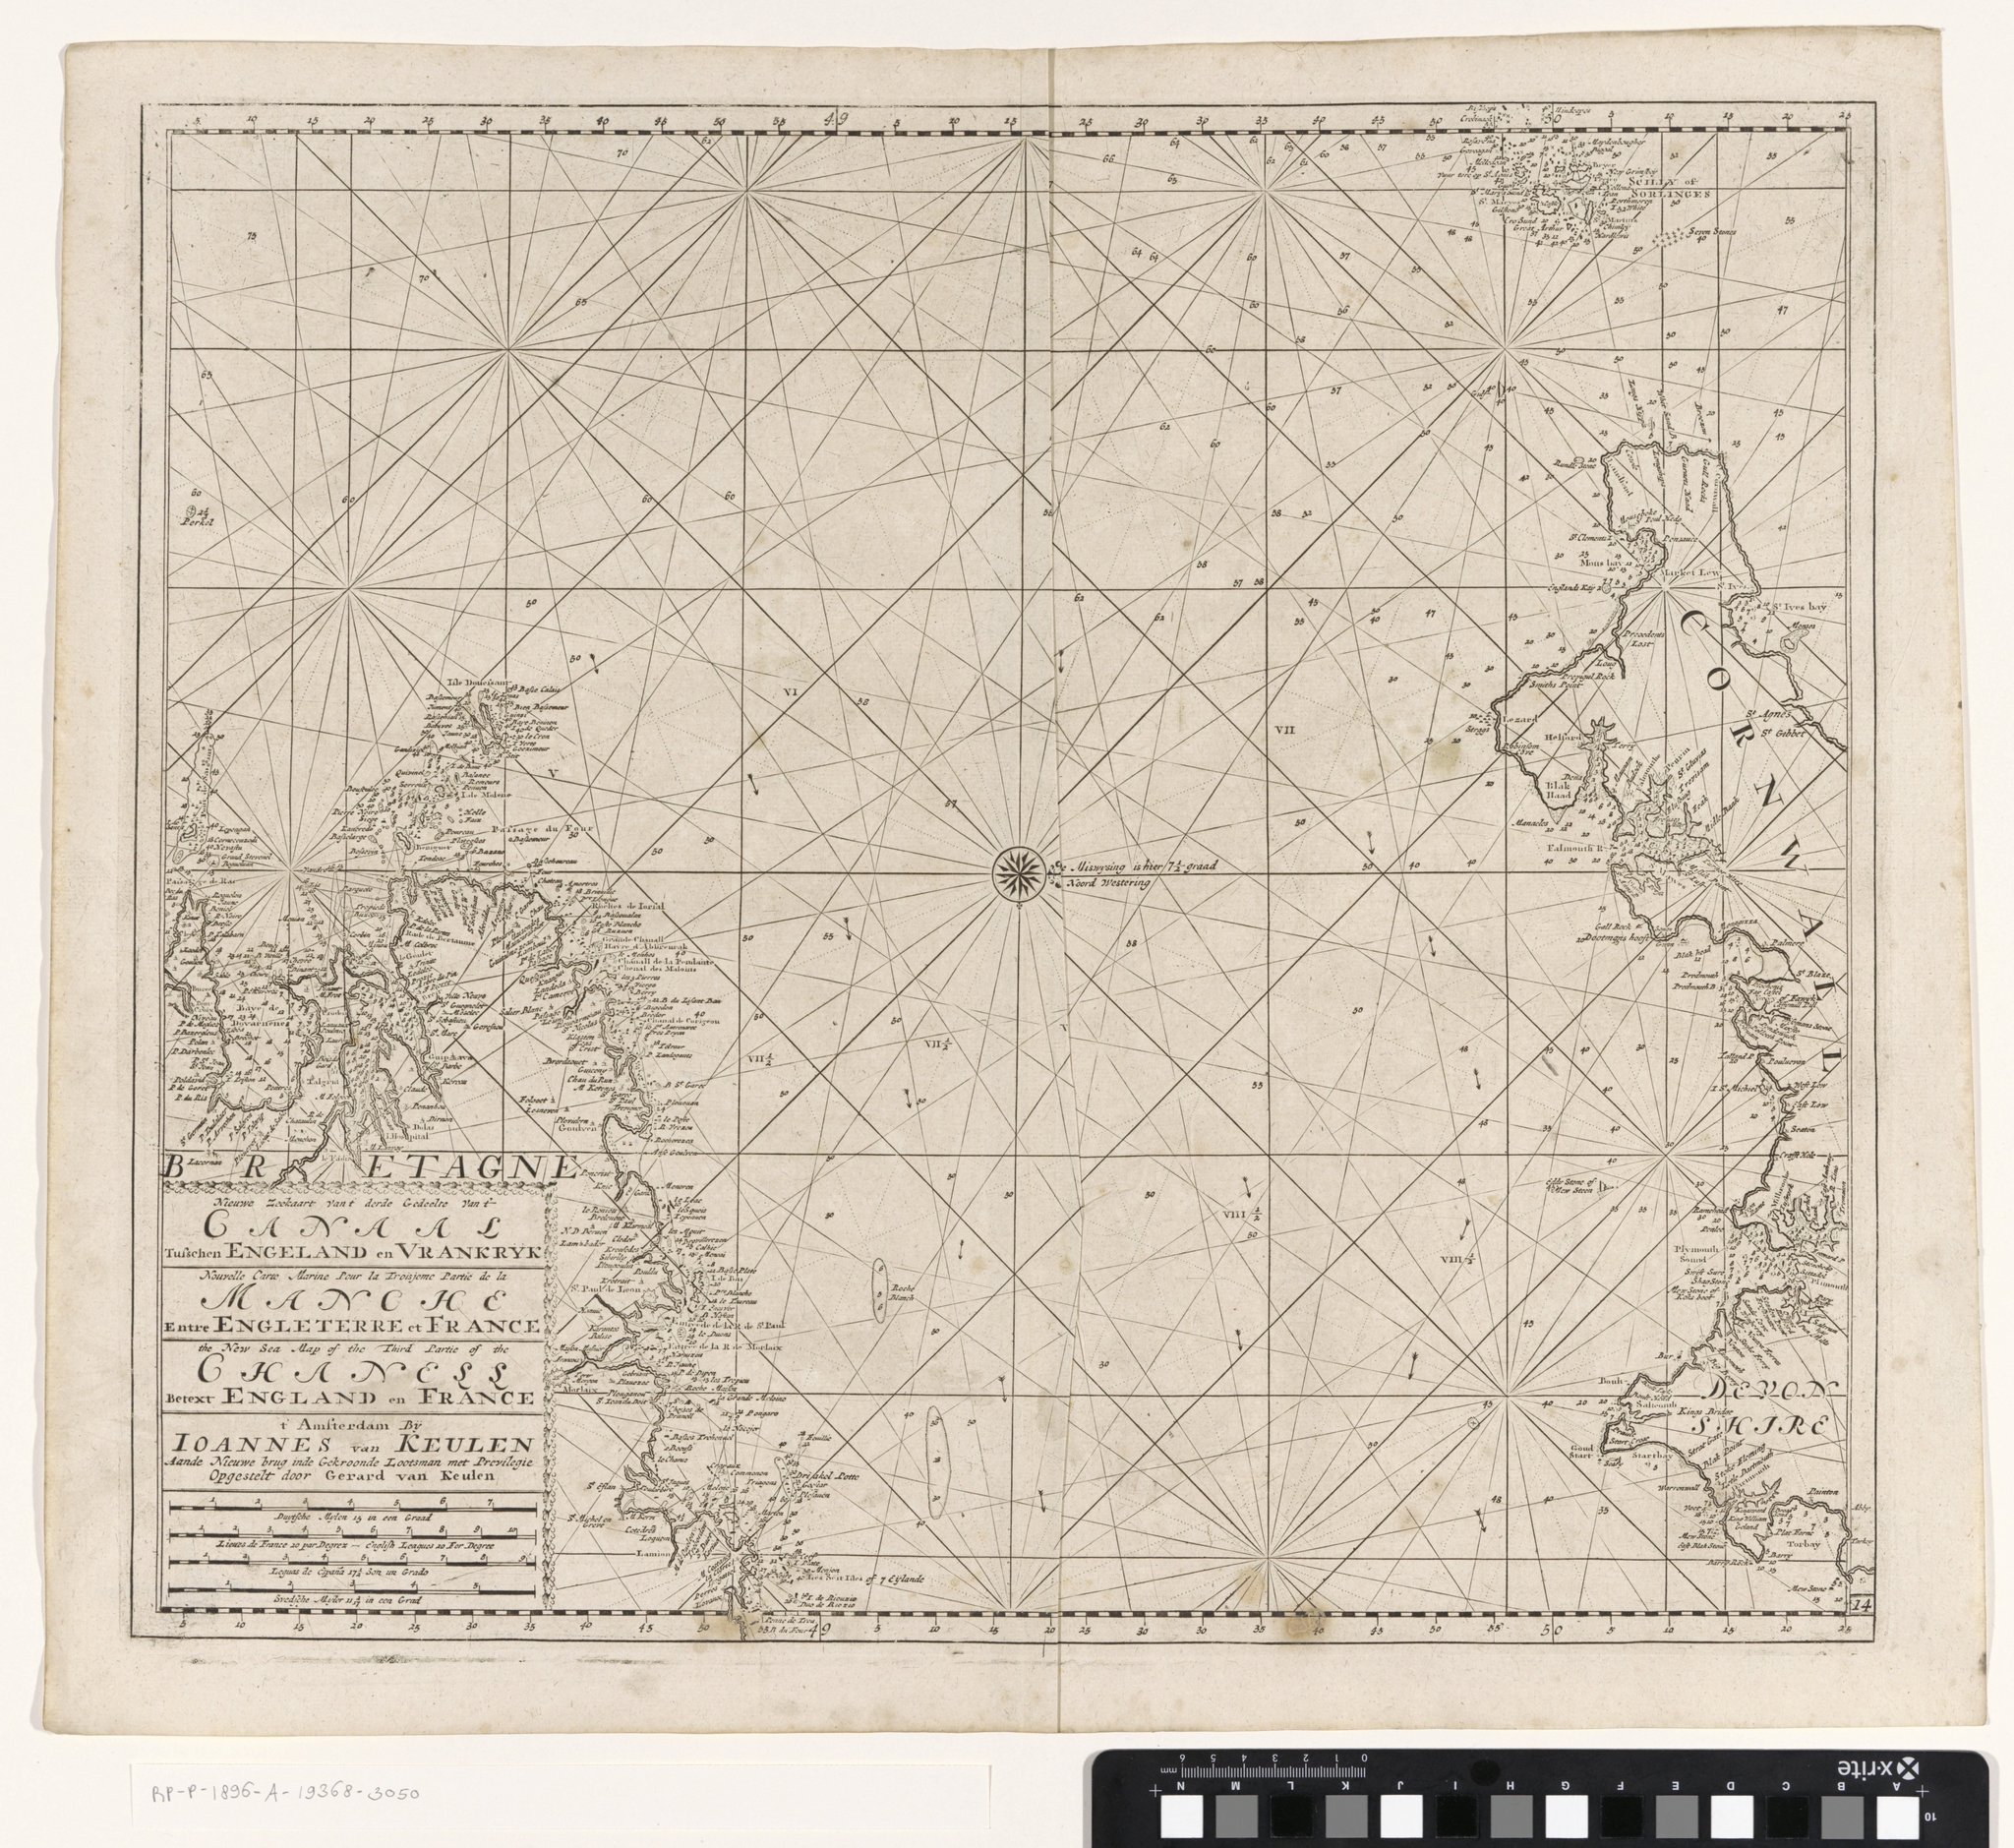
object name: print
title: Nieuwe Zeekaart van t' derde Gedeelte van t' Canaal Tuschen Engeland en Vrankryk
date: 1688-1803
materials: paper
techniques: engraving, etching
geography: amsterdam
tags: english channel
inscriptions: collector's mark: Lugt 2228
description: Paskaart van een gedeelte van Het Kanaal, de zeestraat tussen Groot-Brittannië en Frankrijk, met een kompasroos. Linksonder een cartouche met de titel, het adres van de uitgever en de schaalverdeling.